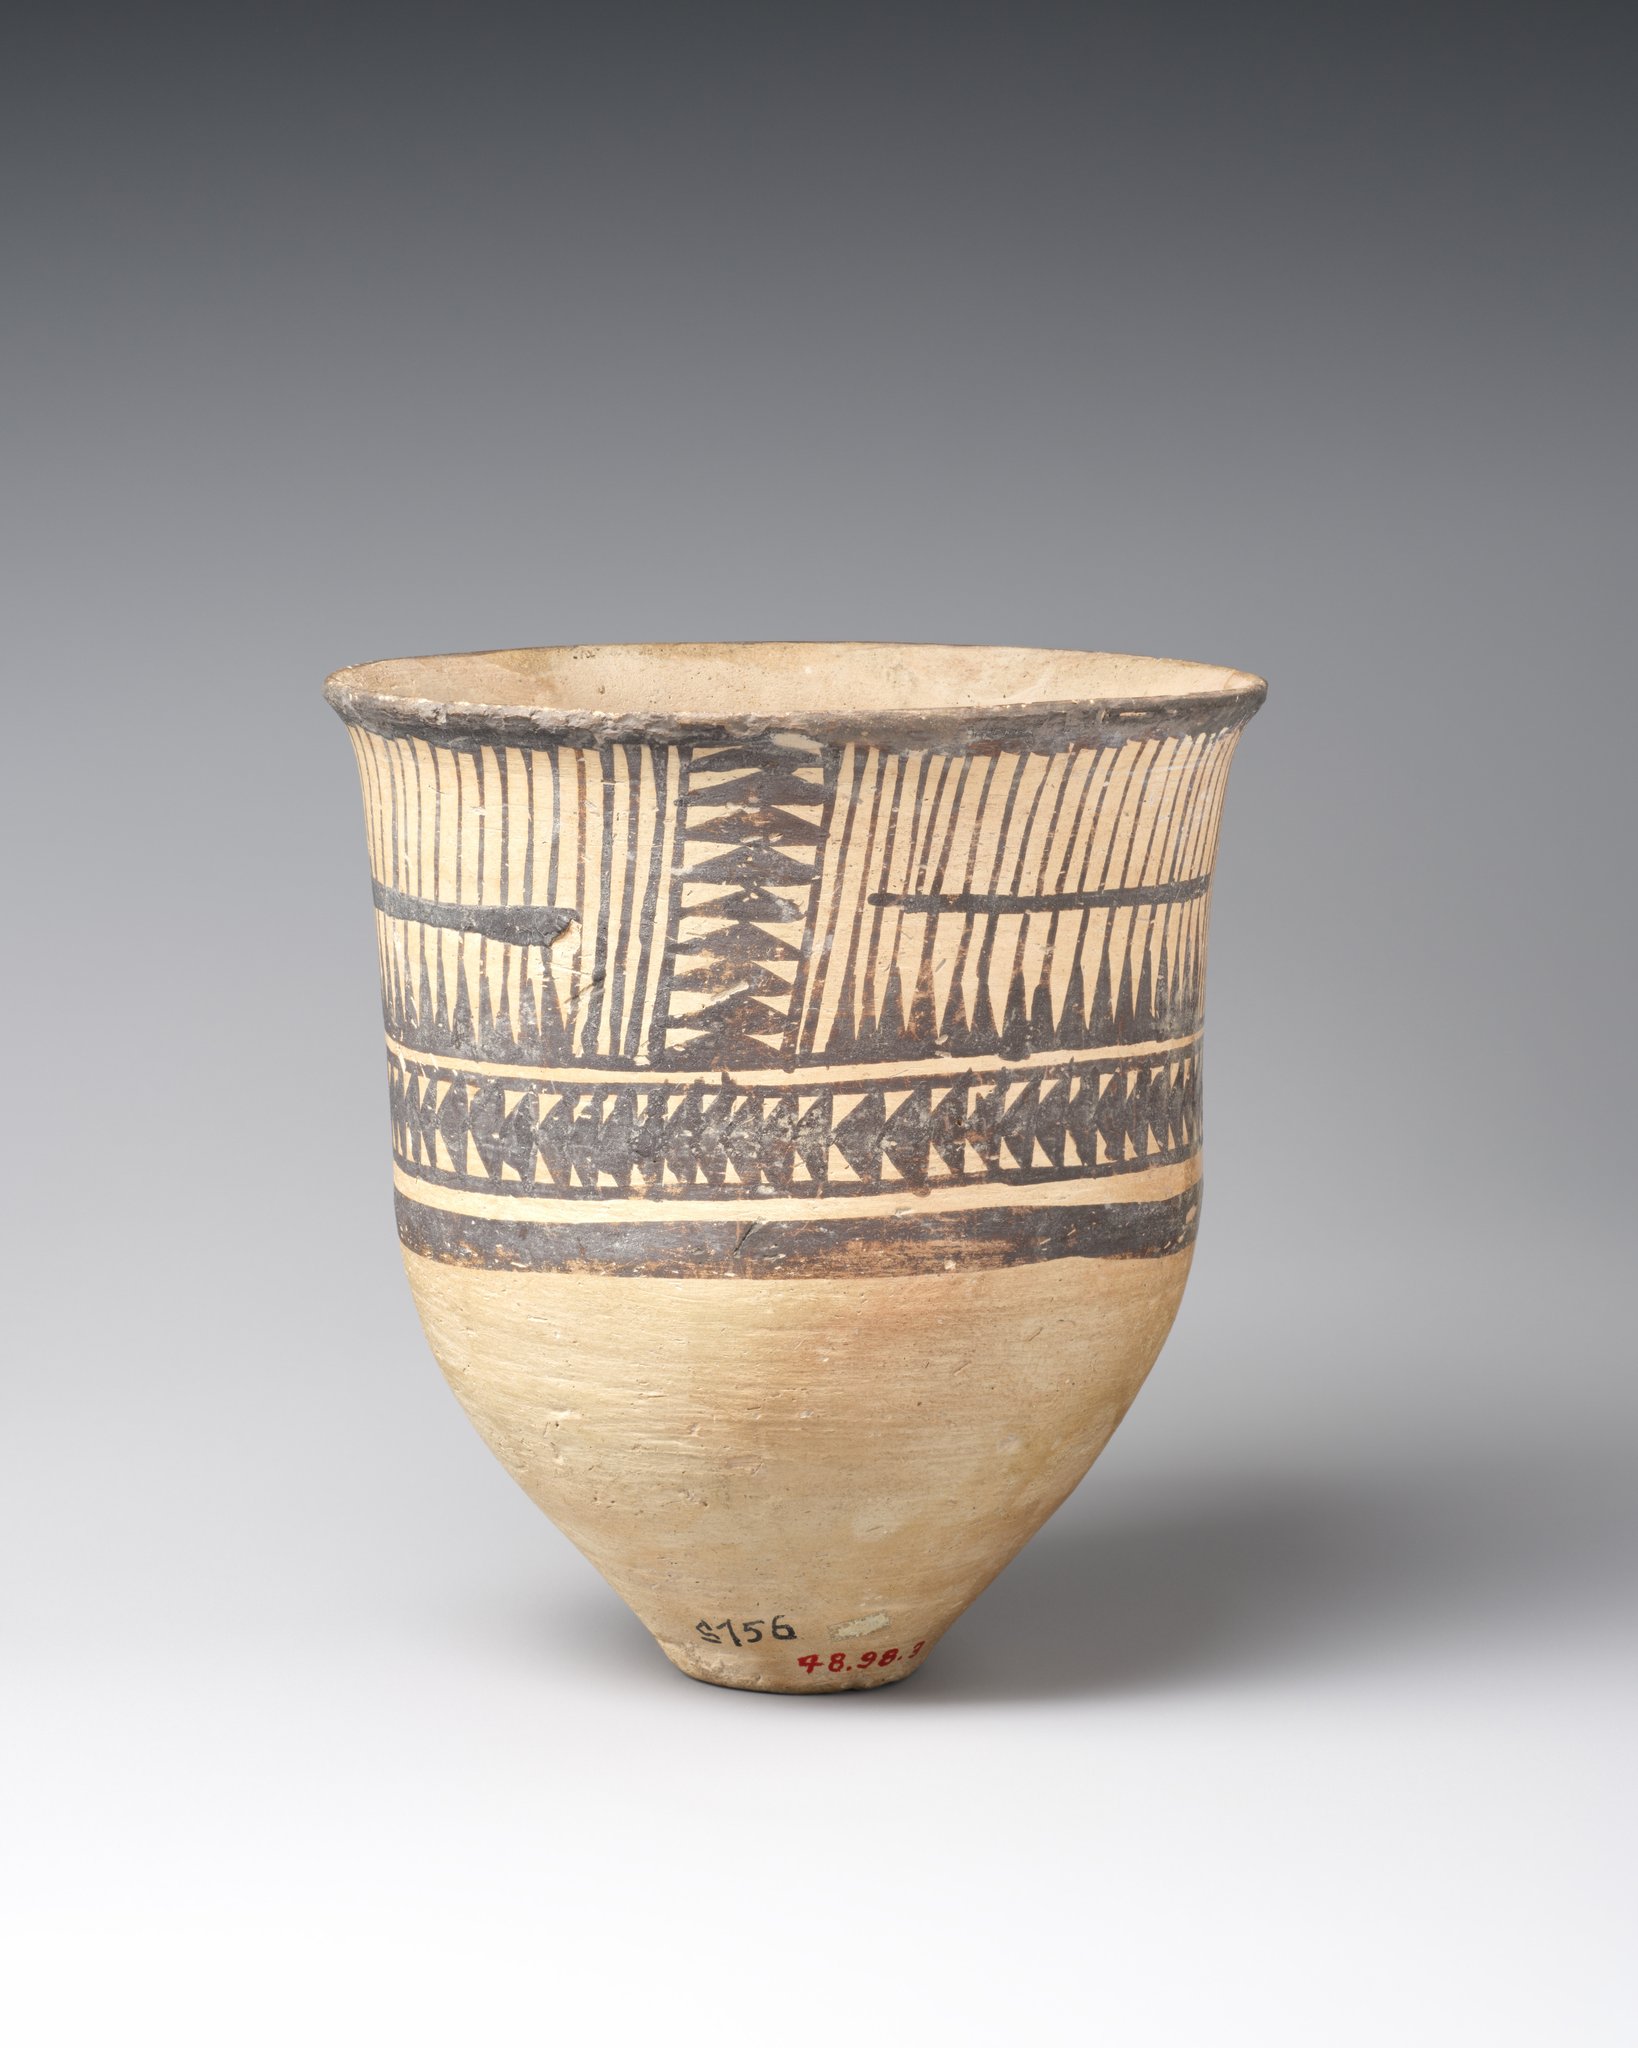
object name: beaker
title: Beaker with geometric decoration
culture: iranian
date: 4000-3600 BCE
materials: ceramic, paint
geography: iran